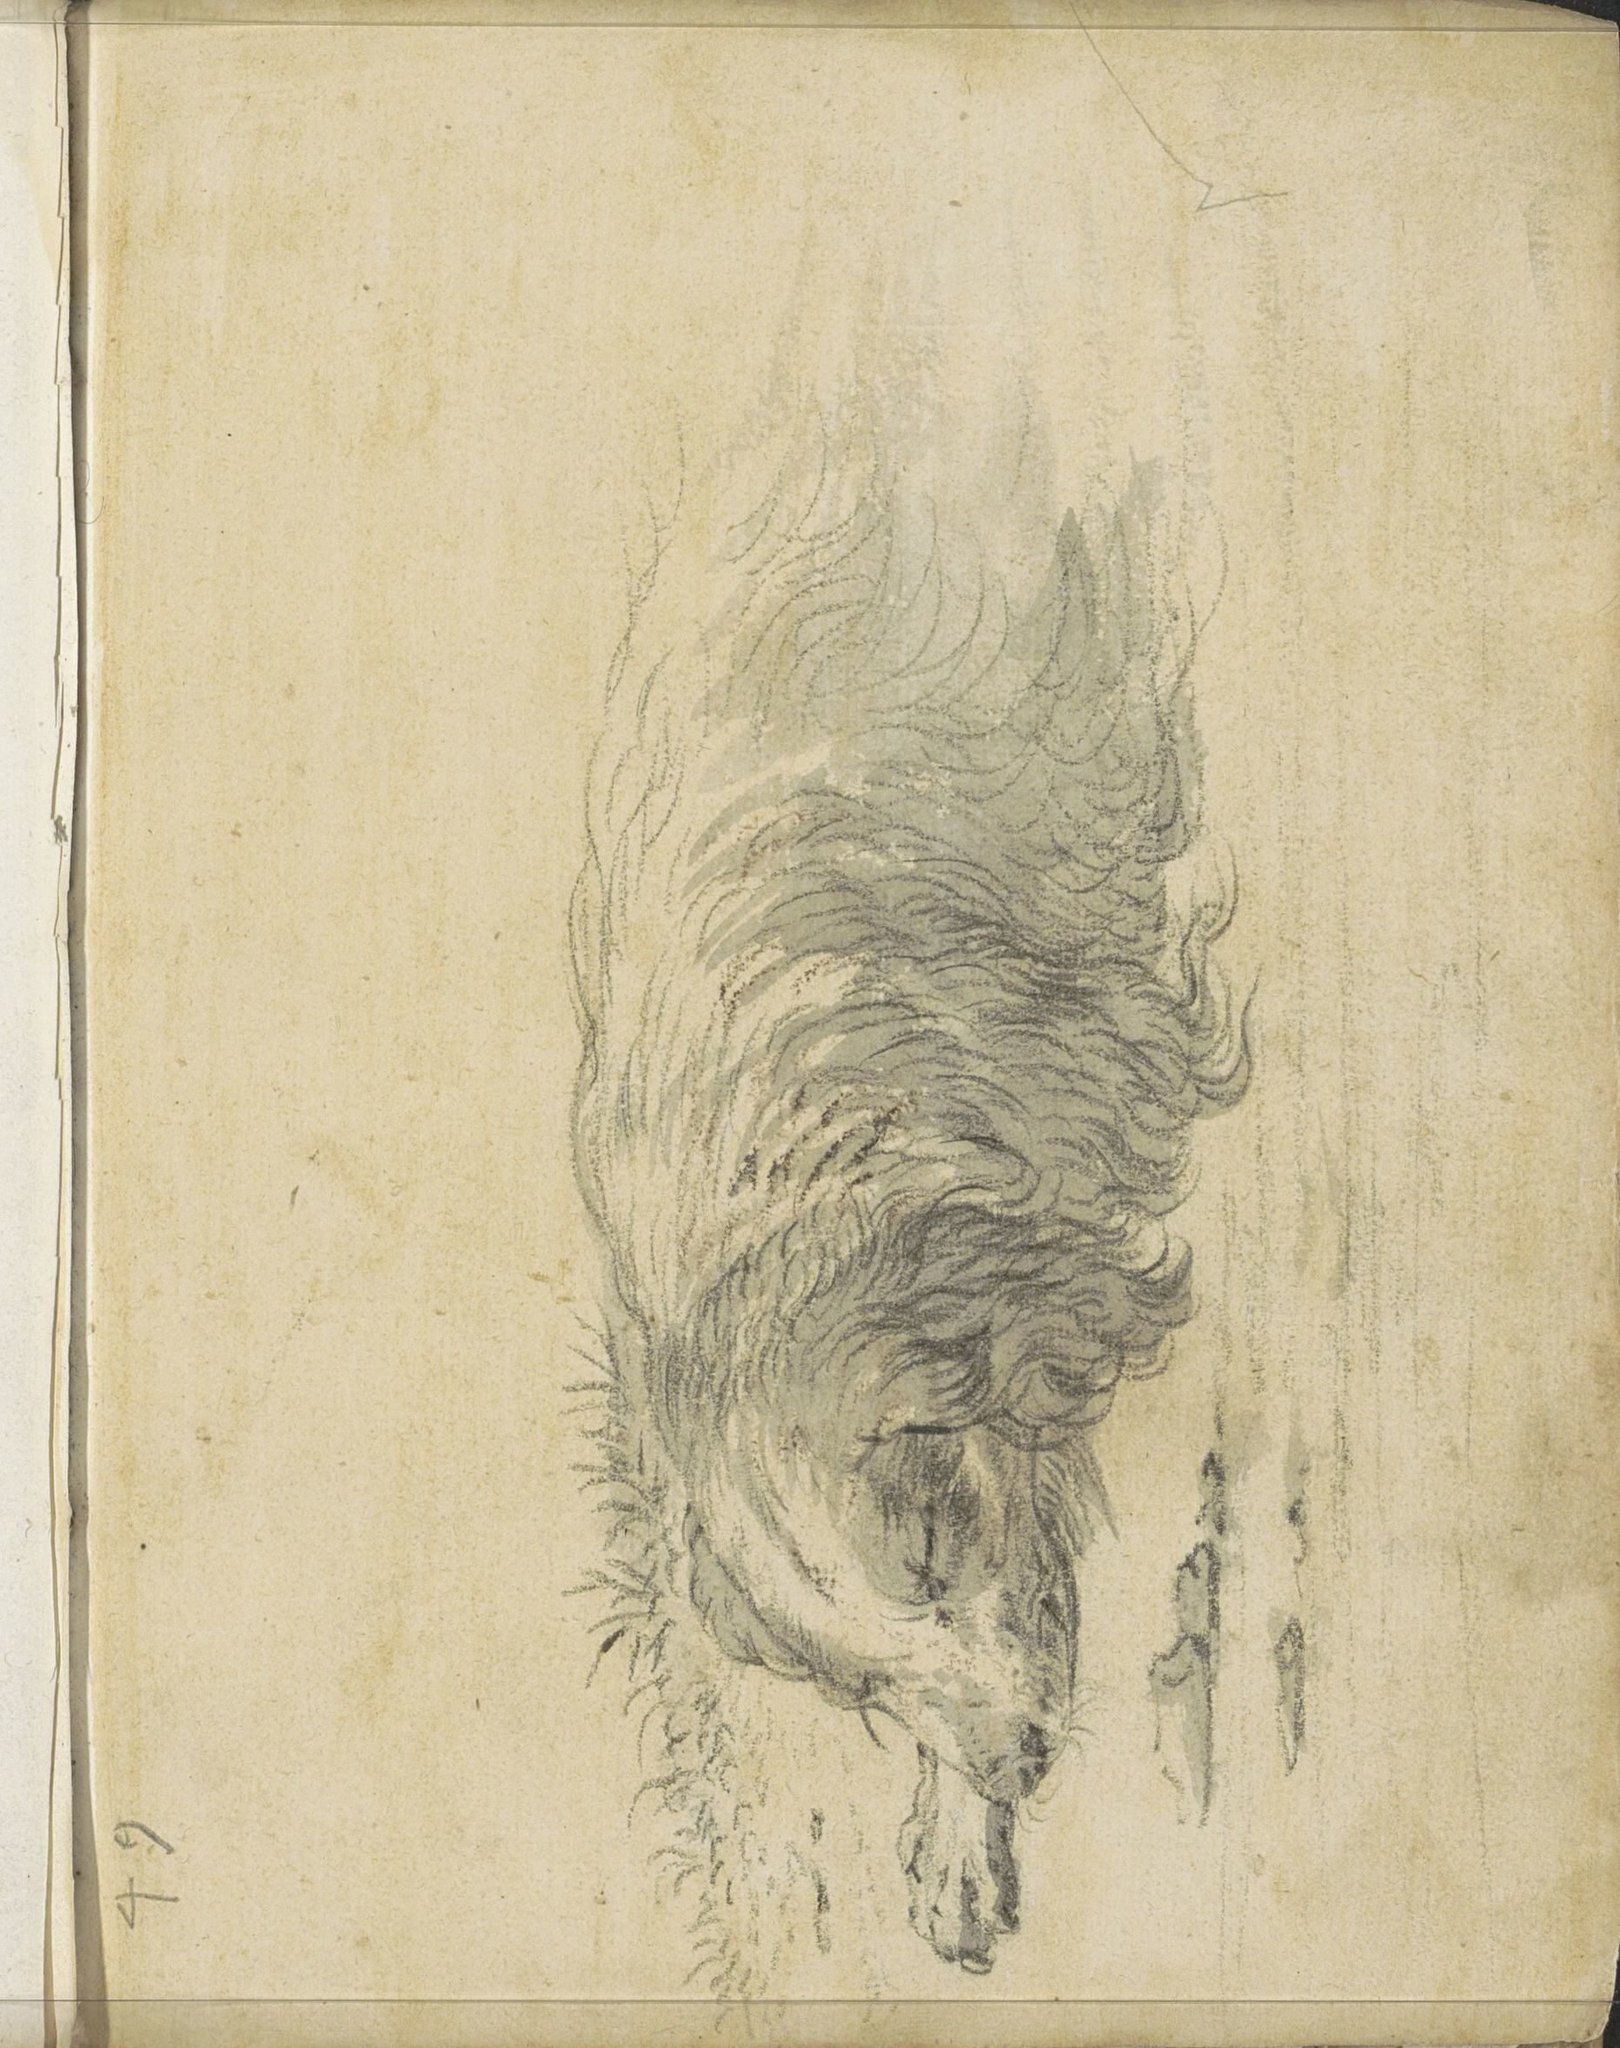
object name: sketchbook leaf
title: Liggende hond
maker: cornelis saftleven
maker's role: draughtsman, painter, print maker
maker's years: 1607-1681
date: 1666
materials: chalk, ink, paper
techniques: brush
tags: dog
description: Blad 49 recto uit een schetsboek met 49 bladen.